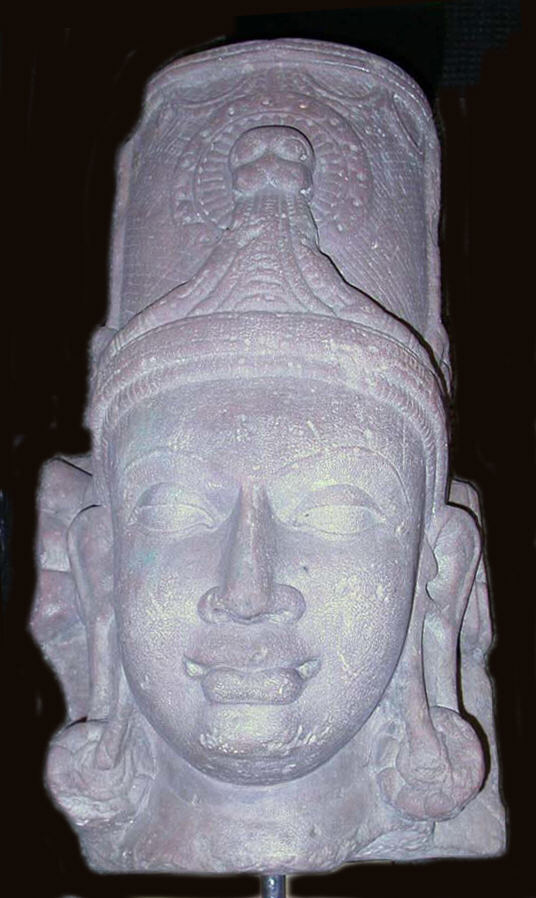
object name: head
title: Head of a Male Deity (Study Collection)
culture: indian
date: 1901-2000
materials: stone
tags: heads